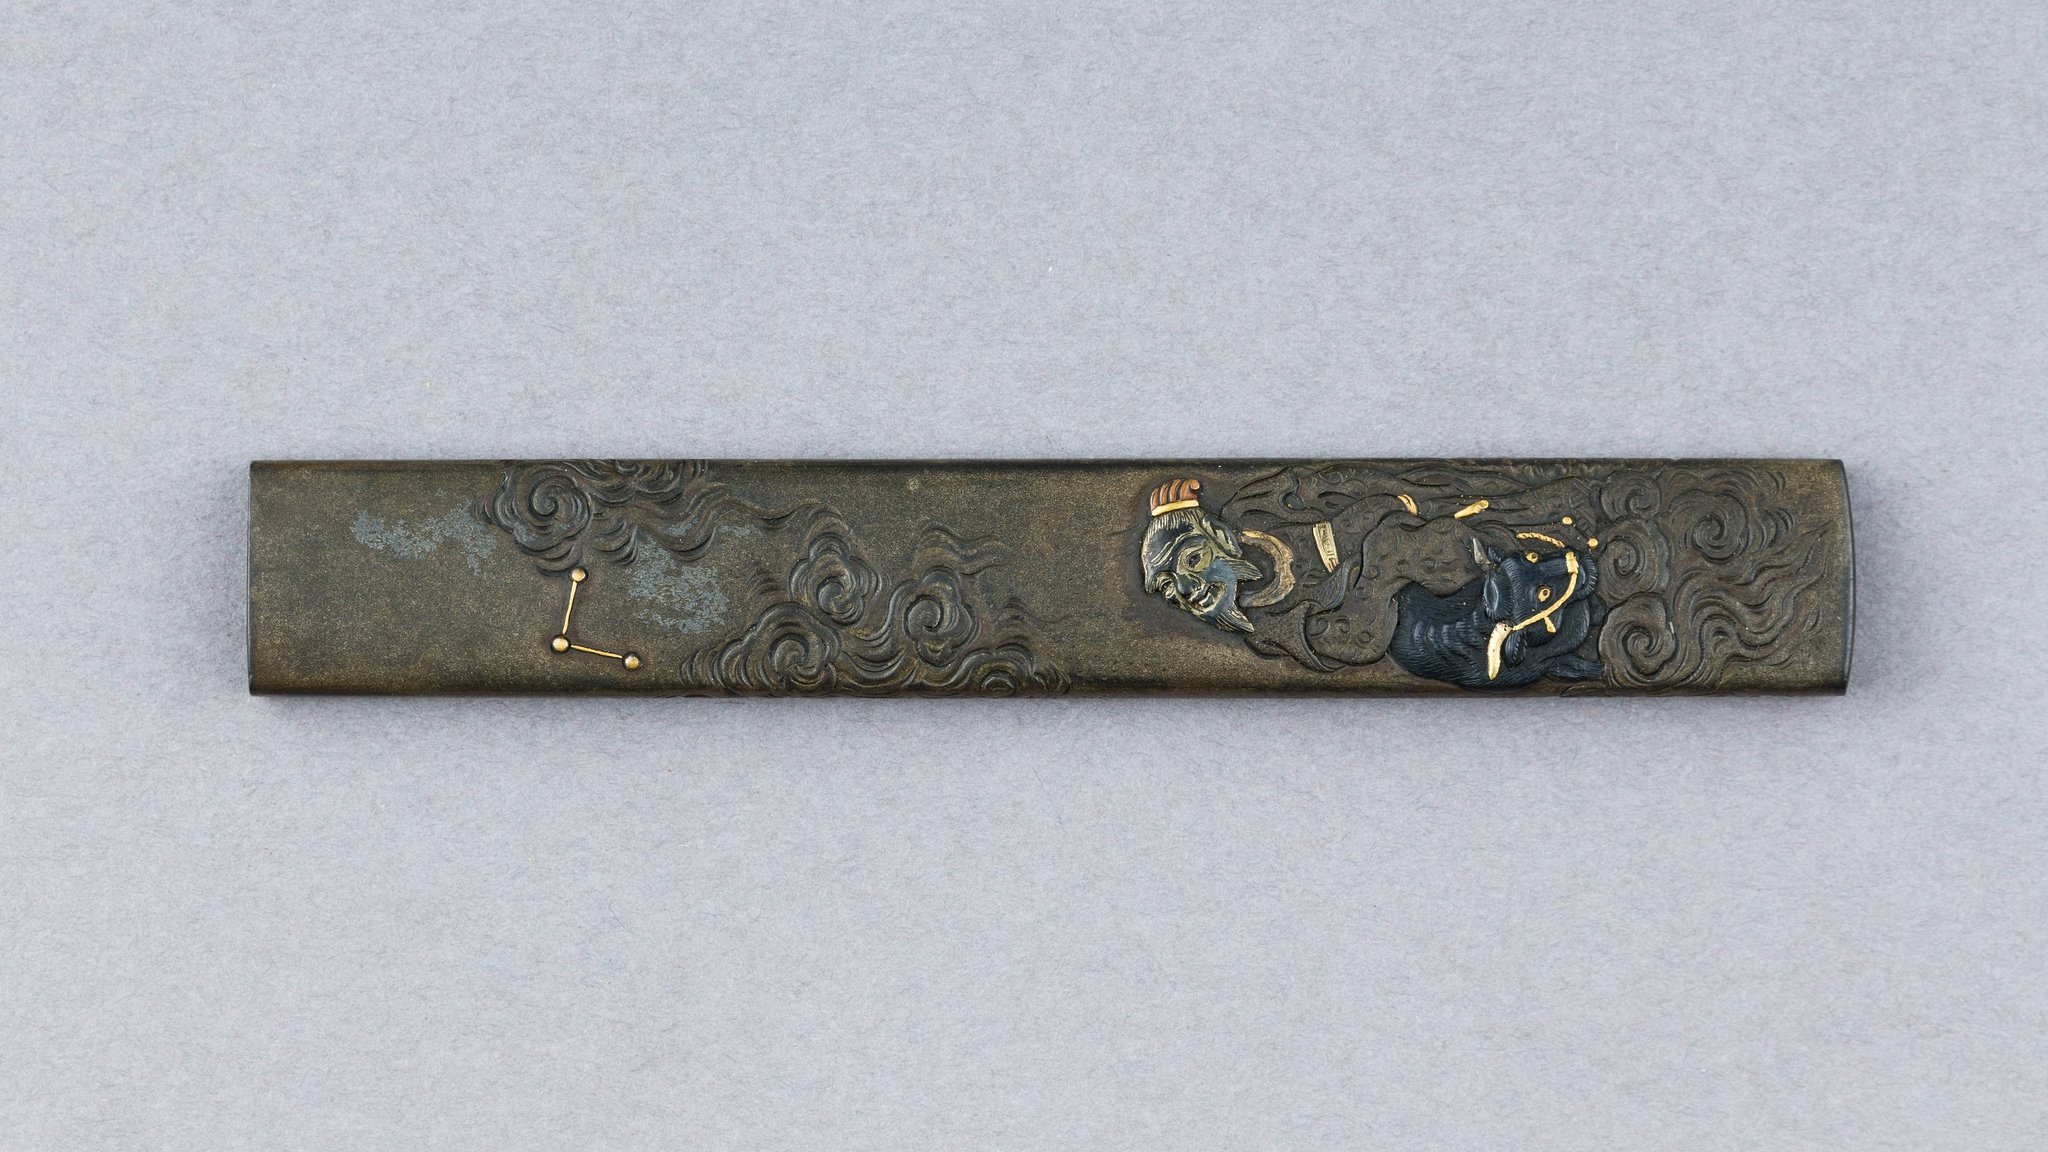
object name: knife handle kozuka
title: Knife Handle (Kozuka)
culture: japanese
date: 1615-1868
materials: copper, gold alloy, silver alloy, gold, silver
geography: japan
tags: men,ox